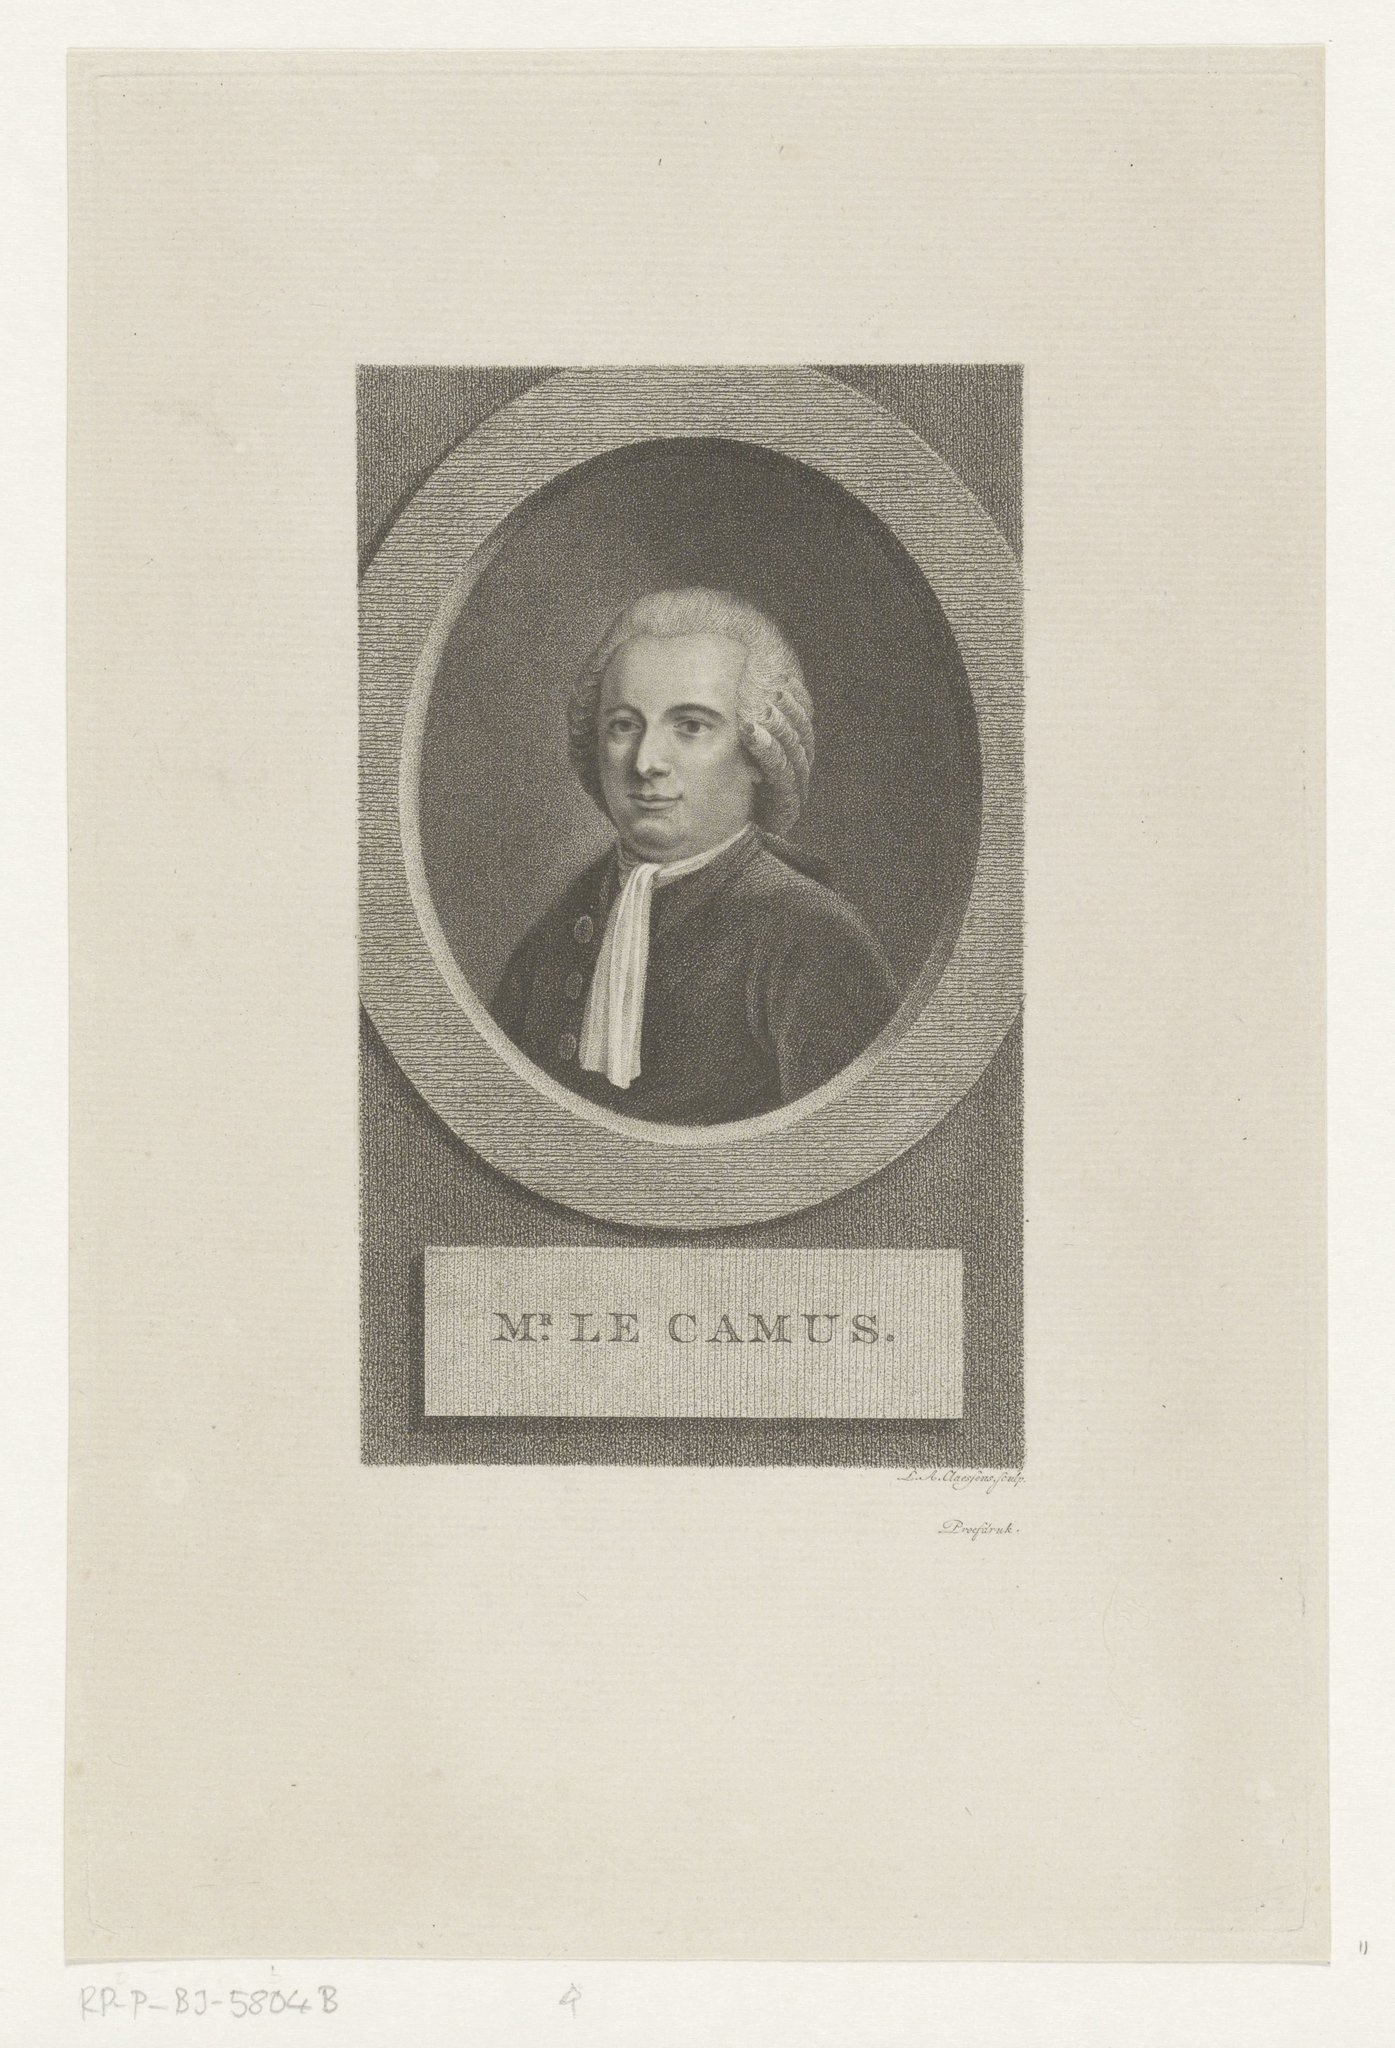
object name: print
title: Portret van Armand Gaston Camus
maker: lambertus antonius claessens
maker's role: draughtsman, print maker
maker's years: 1763-1834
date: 1792-1808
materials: paper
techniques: engraving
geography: amsterdam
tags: jurist, armand gaston camus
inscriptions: collector's mark: Lugt 2228